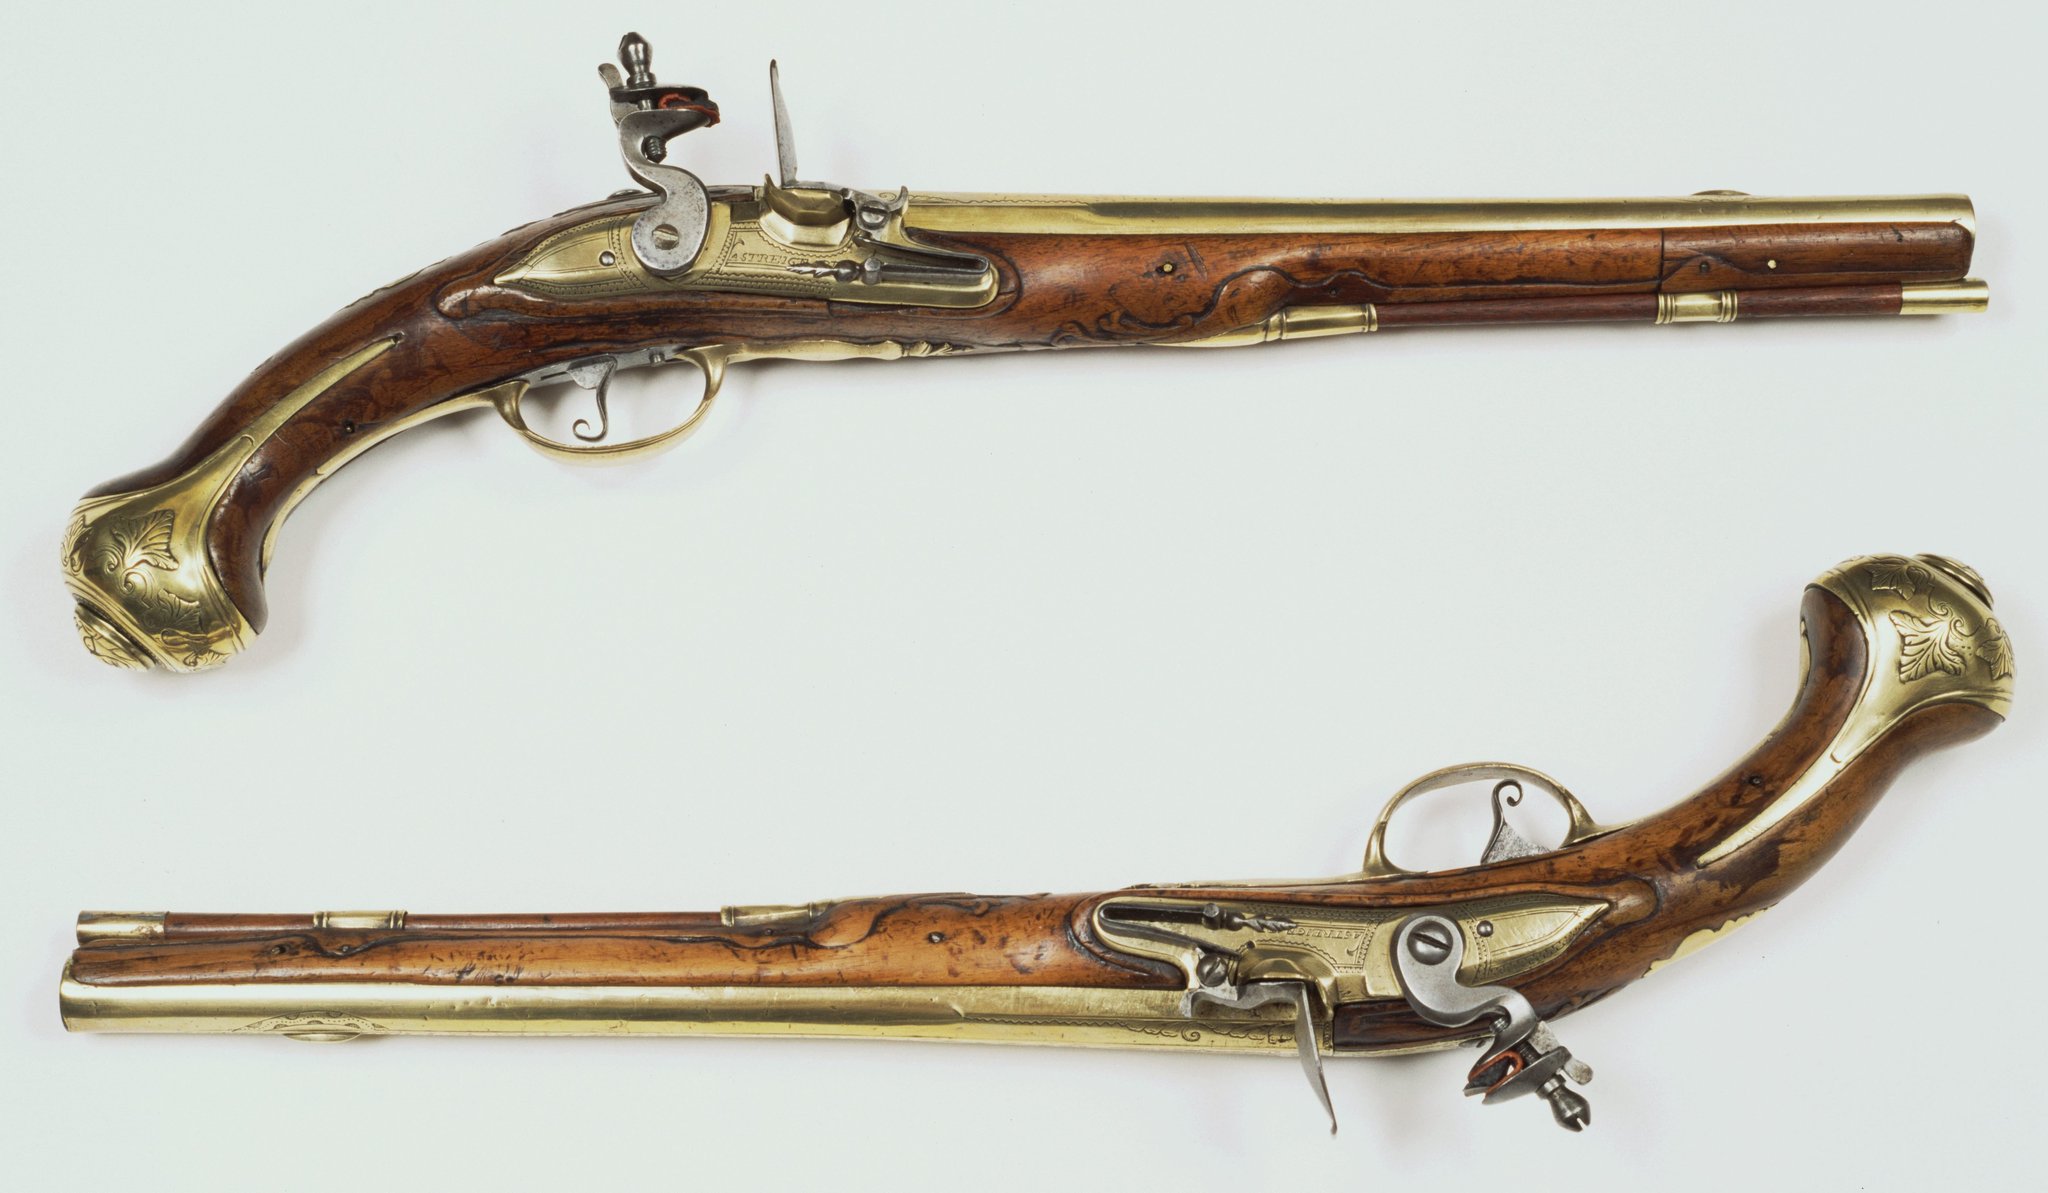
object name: flintlock pistol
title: Vuursteenpistool met batterijslot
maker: a. streignard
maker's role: geweermaker, pistoolmaker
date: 1770-1780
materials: brass, steel, wood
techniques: engraving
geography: western europe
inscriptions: : ‘A. Streignard’